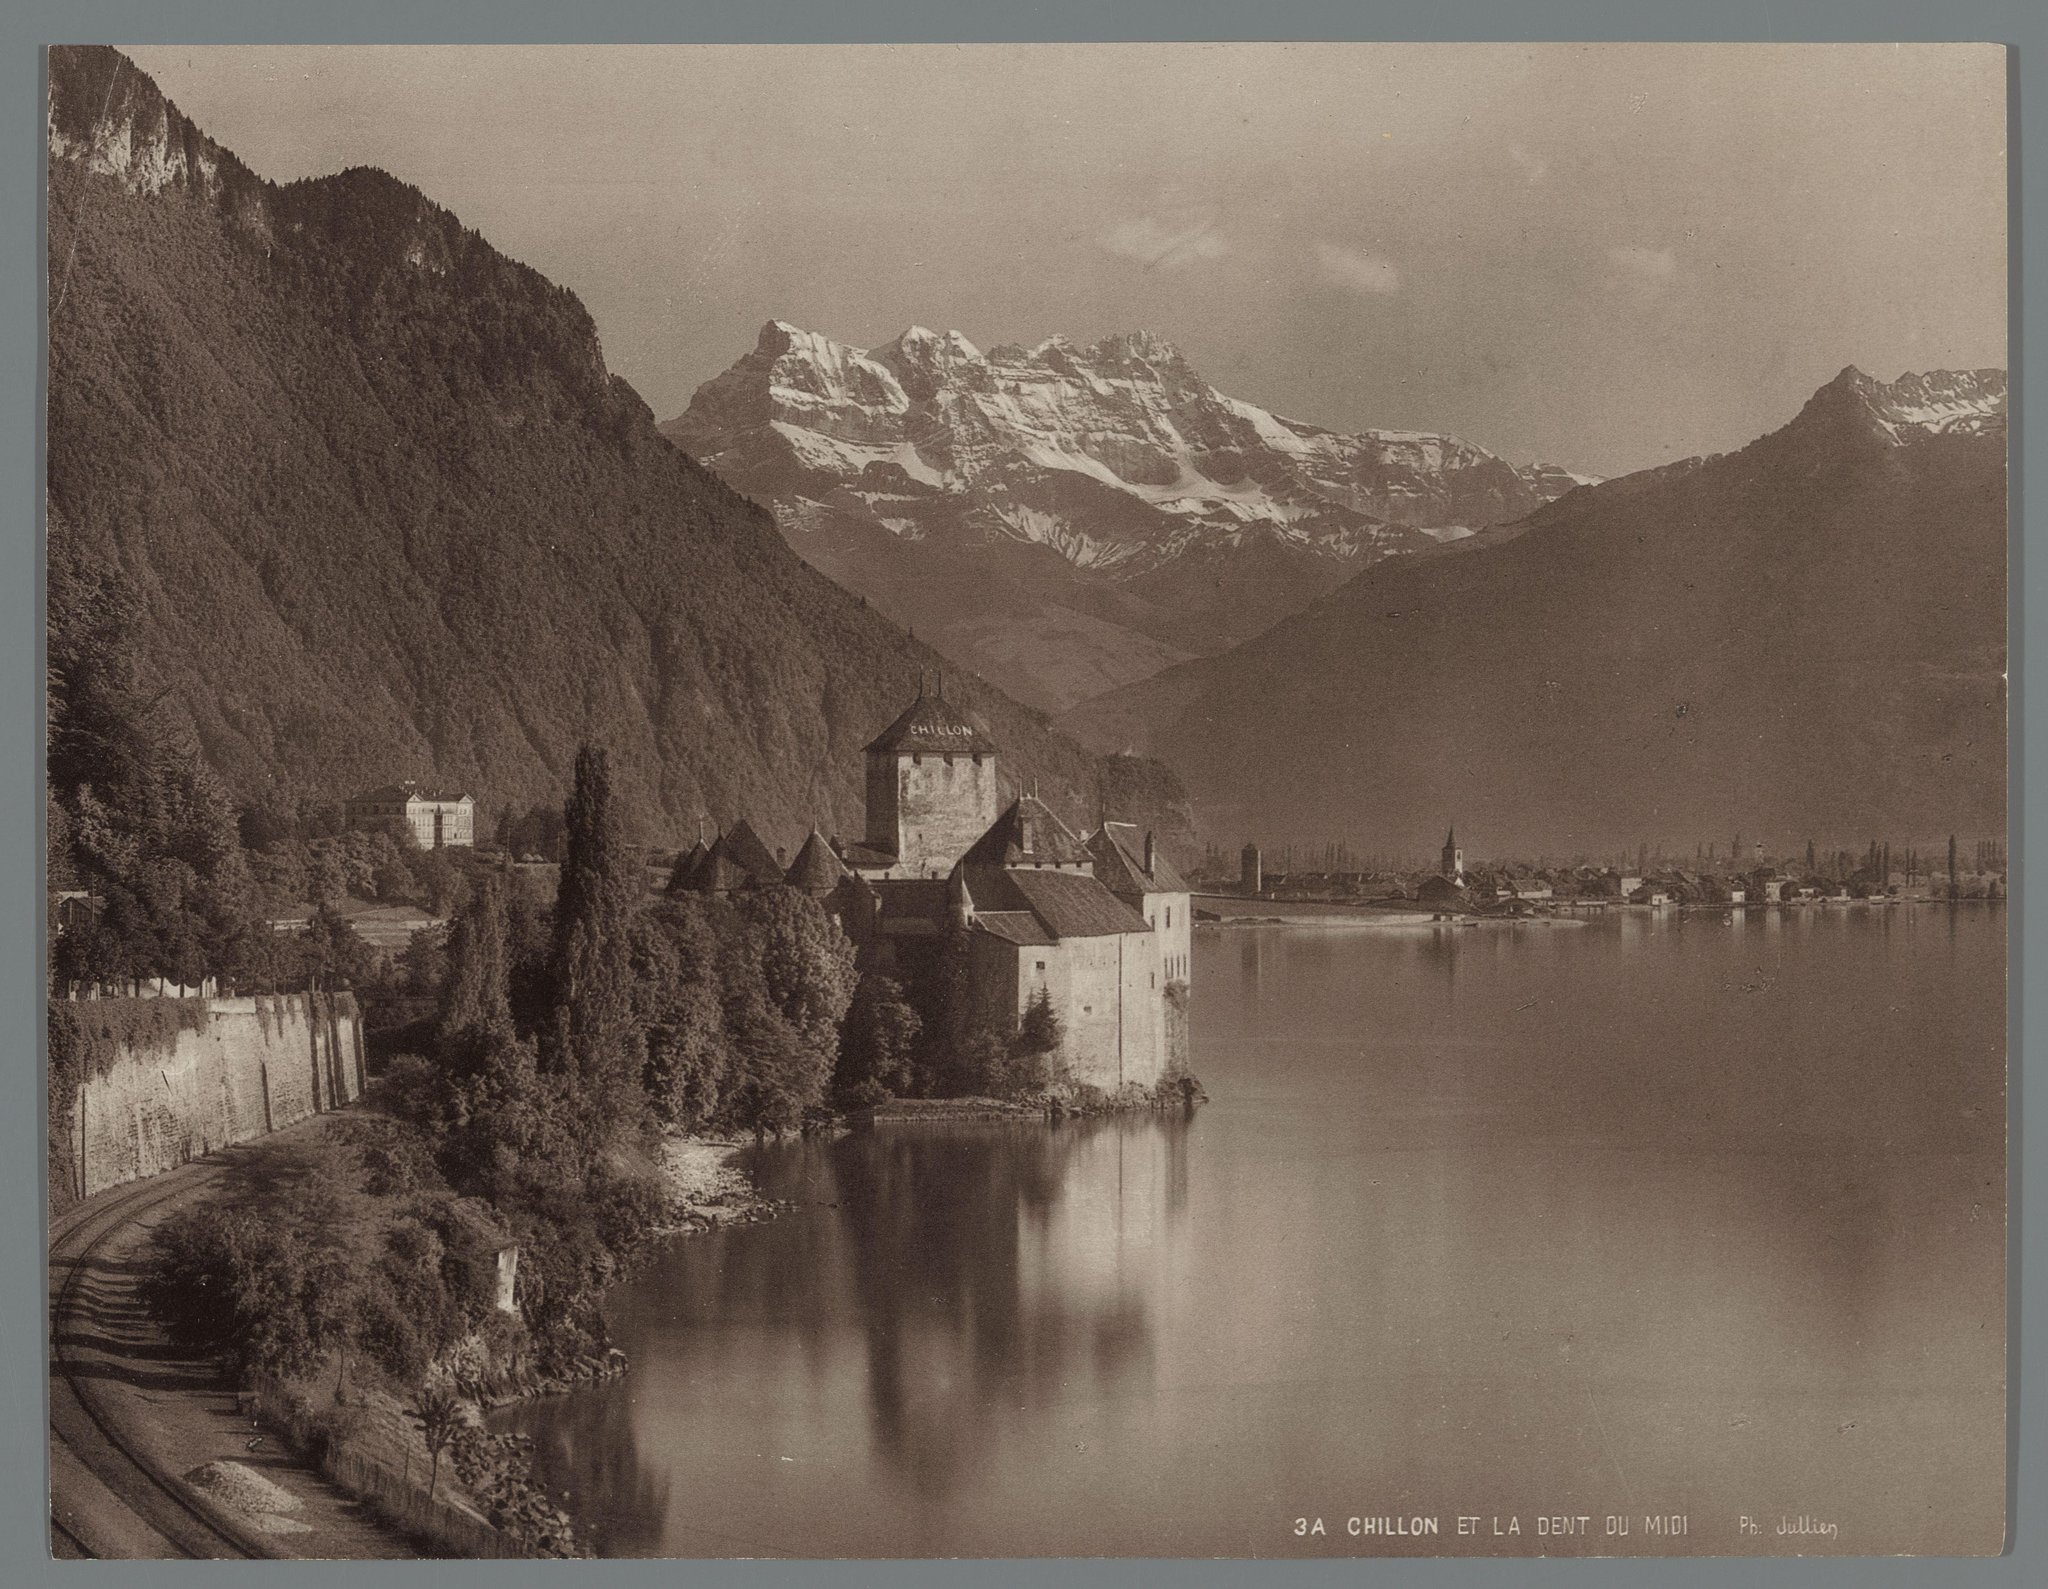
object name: photomechanical print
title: Kasteel van Chillon aan het Meer van Genève, in de verte de Dents du Midi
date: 1870-1900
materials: paper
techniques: photograph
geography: vaud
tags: castle, lake, mountains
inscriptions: number: ‘3A’